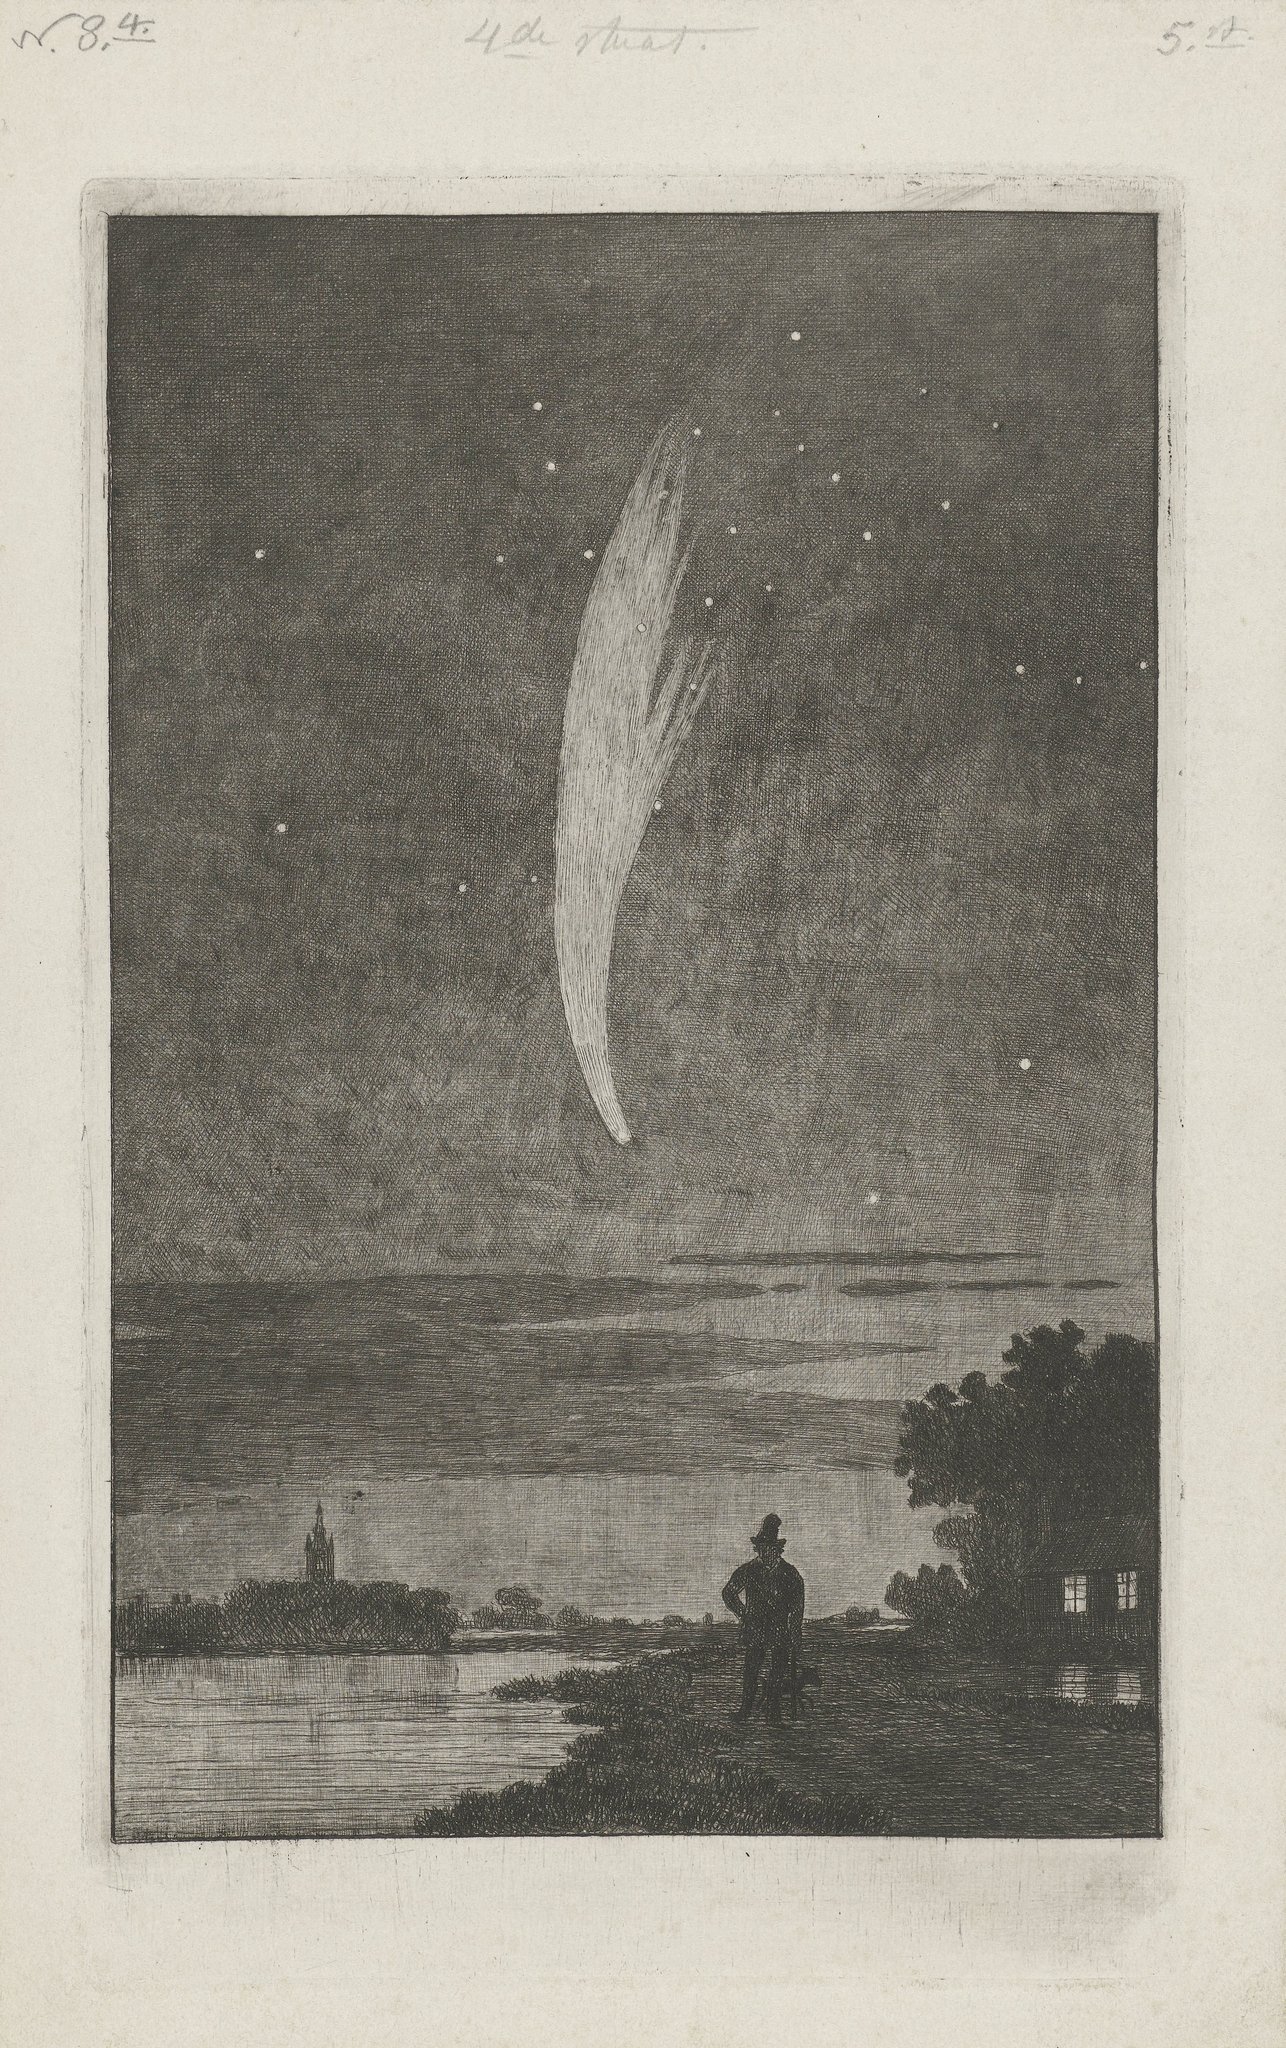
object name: print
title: De komeet van Donati, 1858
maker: cornelis van der griendt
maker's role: draughtsman, painter, print maker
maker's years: 1827-1918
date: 1858-1860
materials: paper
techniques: etching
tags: comet, river (+ landscape with figures, staffage)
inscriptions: collector's mark: Lugt 2228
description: De komeet van Donati, 10 oktober 1858. Op de voorgrond een man met hond bij een rivier. Op de achtergrond links een kerktoren.